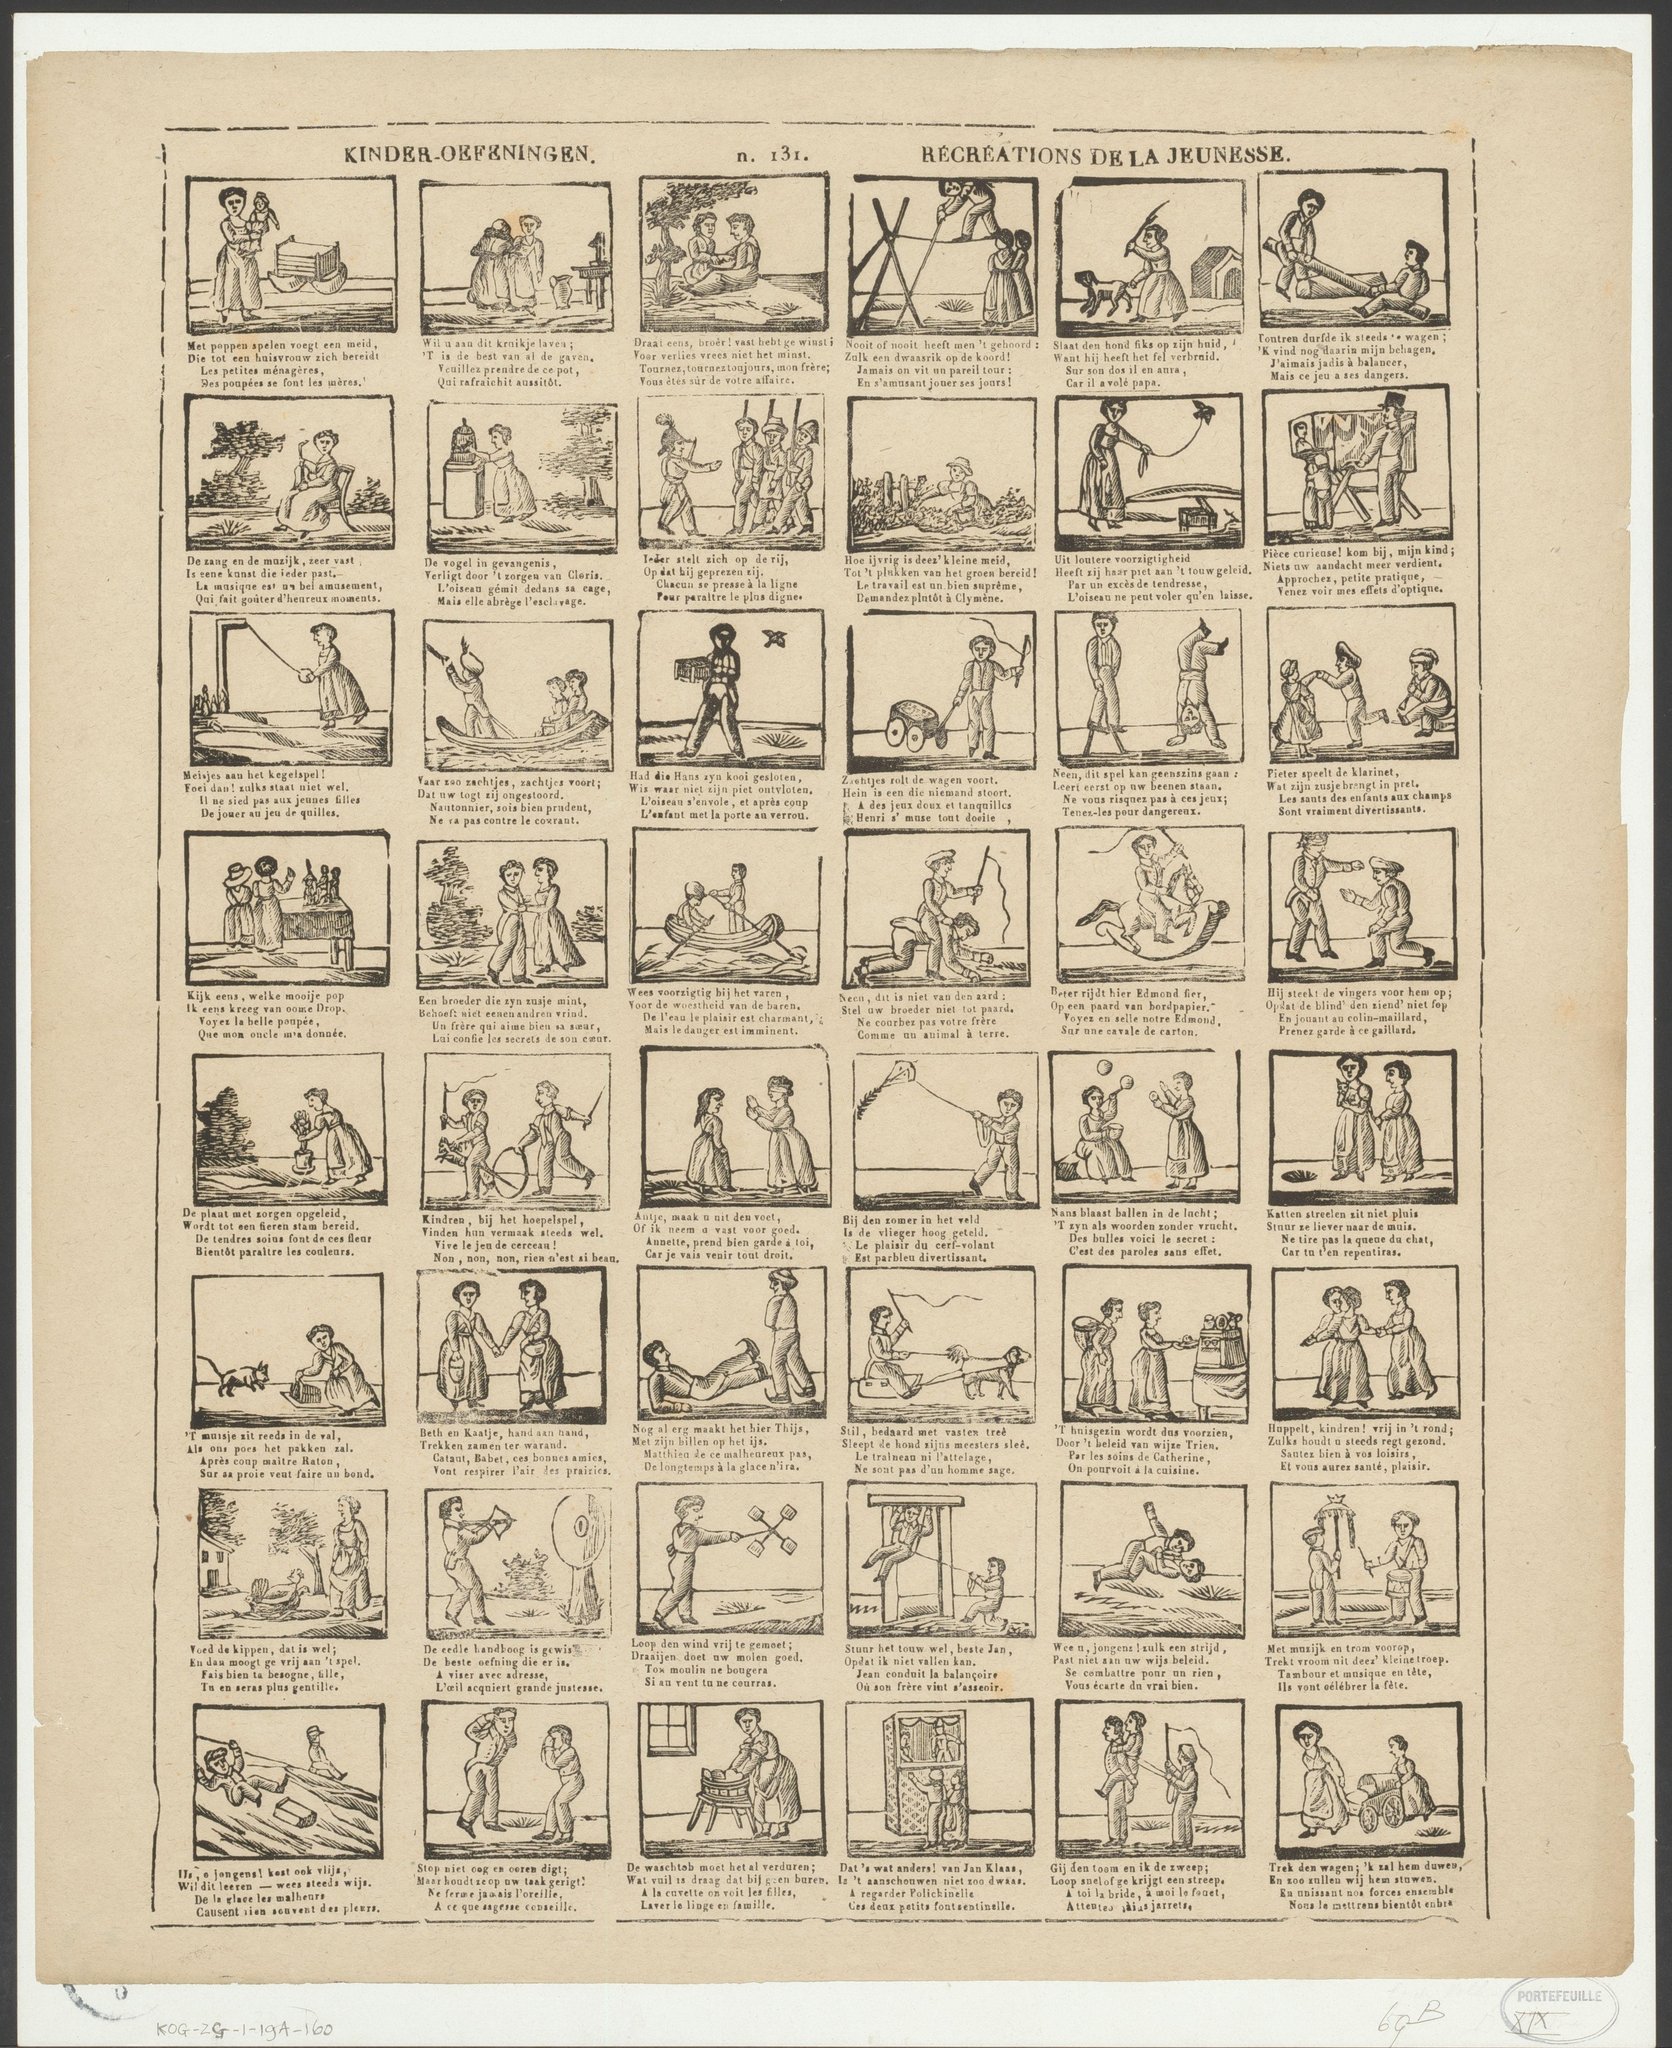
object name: popular print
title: Kinder-oefeningen / Récréations de la jeunesse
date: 1800-1833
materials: paper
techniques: letterpress printing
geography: turnhout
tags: children's games and plays, predatory birds: kite, swinging (children's game), games using special objects (marbles, top, hoop, etc.), seesaw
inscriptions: collector's mark: Lugt 1641, stamp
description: Blad met 48 voorstellingen van kinderspelen, waaronder wippen, vliegeren, boogschieten, schommelen en hoepelen. Onder elke afbeelding een tweeregelig vers in het Nederlands en in het Frans. Bovenaan genummerd: n. 131. Onderwerpsrubrieken binnen de Atlas Zeden en Gewoonten: Zeden en Gewoonten in Engeren Zin, Des menschen beging, midden en einde, Kinderleven – Kinderspel en Kinderprenten.